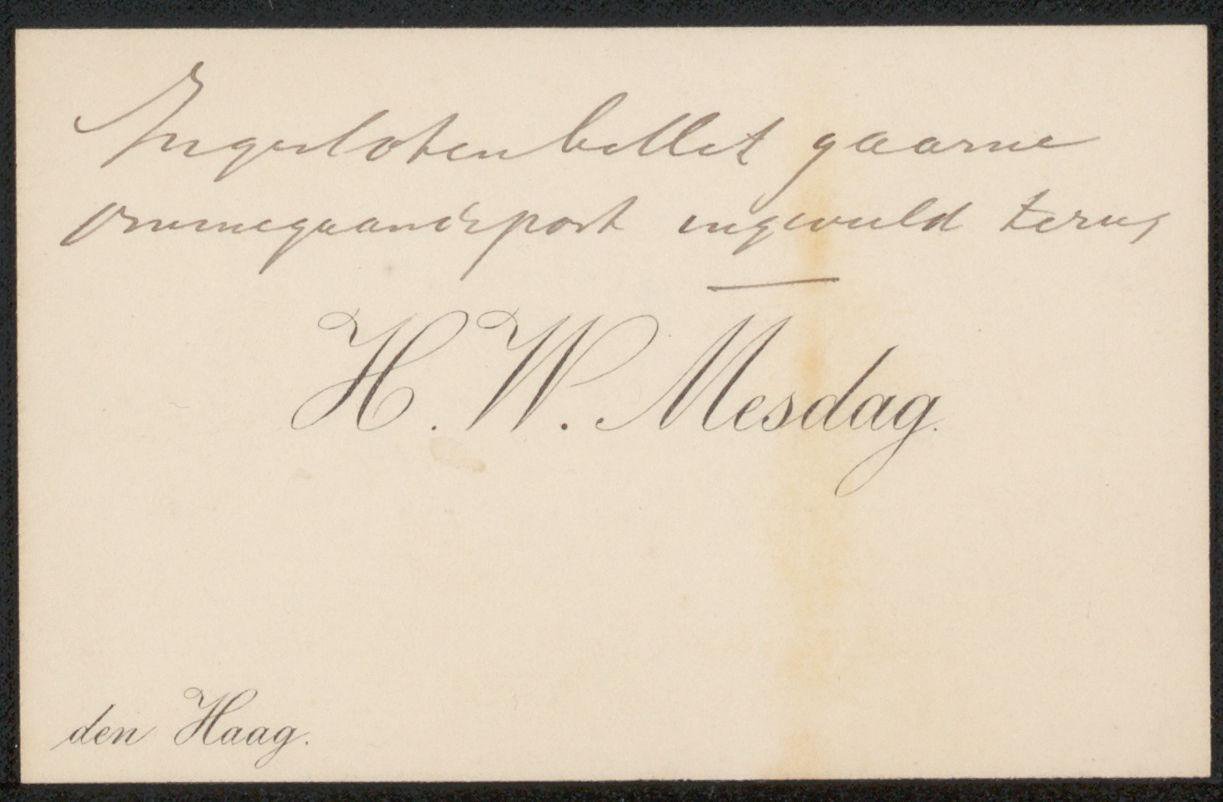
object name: visiting card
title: Visitekaartje aan Philip Zilcken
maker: hendrik willem mesdag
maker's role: draughtsman, painter, print maker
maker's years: 1831-1915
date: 1841-1915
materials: cardboard, ink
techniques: pen, printing, writing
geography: the hague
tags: philip zilcken